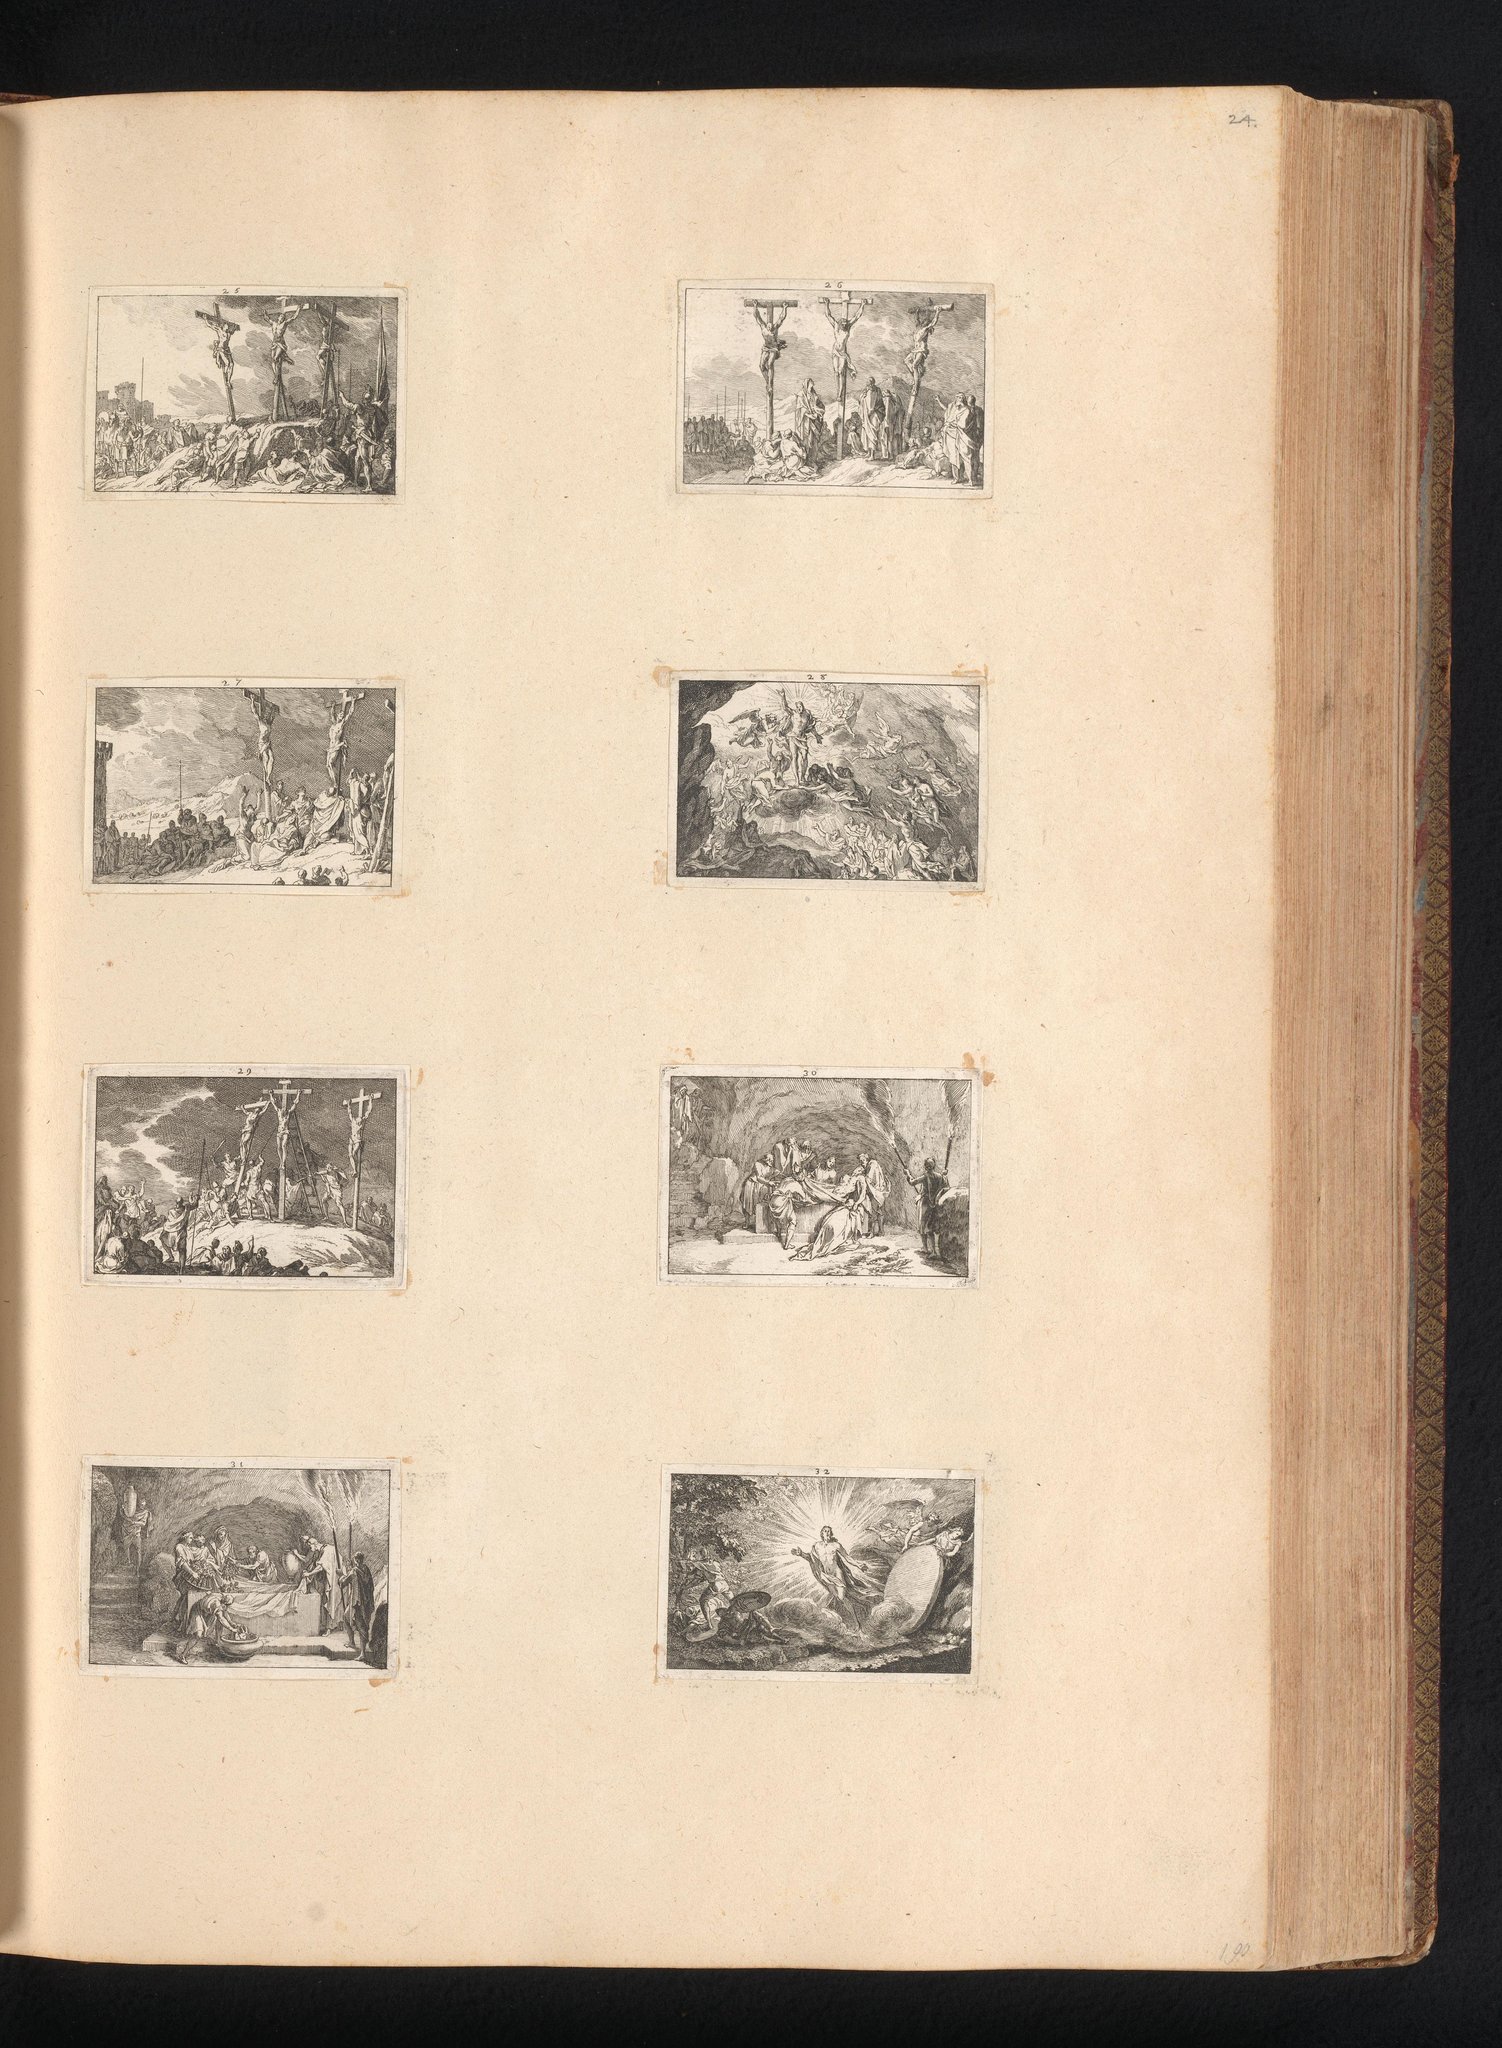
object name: print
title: Voorstellingen van de Passie van Christus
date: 1647-1703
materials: paper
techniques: engraving, etching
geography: france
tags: passion of christ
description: Deze prenten maken deel uit van een serie met 36 voorstellingen van de Passie, opgedragen aan Madame de Maintenon. In het album bevinden zich verschillende staten van de serie: latere staten met de ornamentele lijst en eerdere staten zonder de ornamentele lijst.